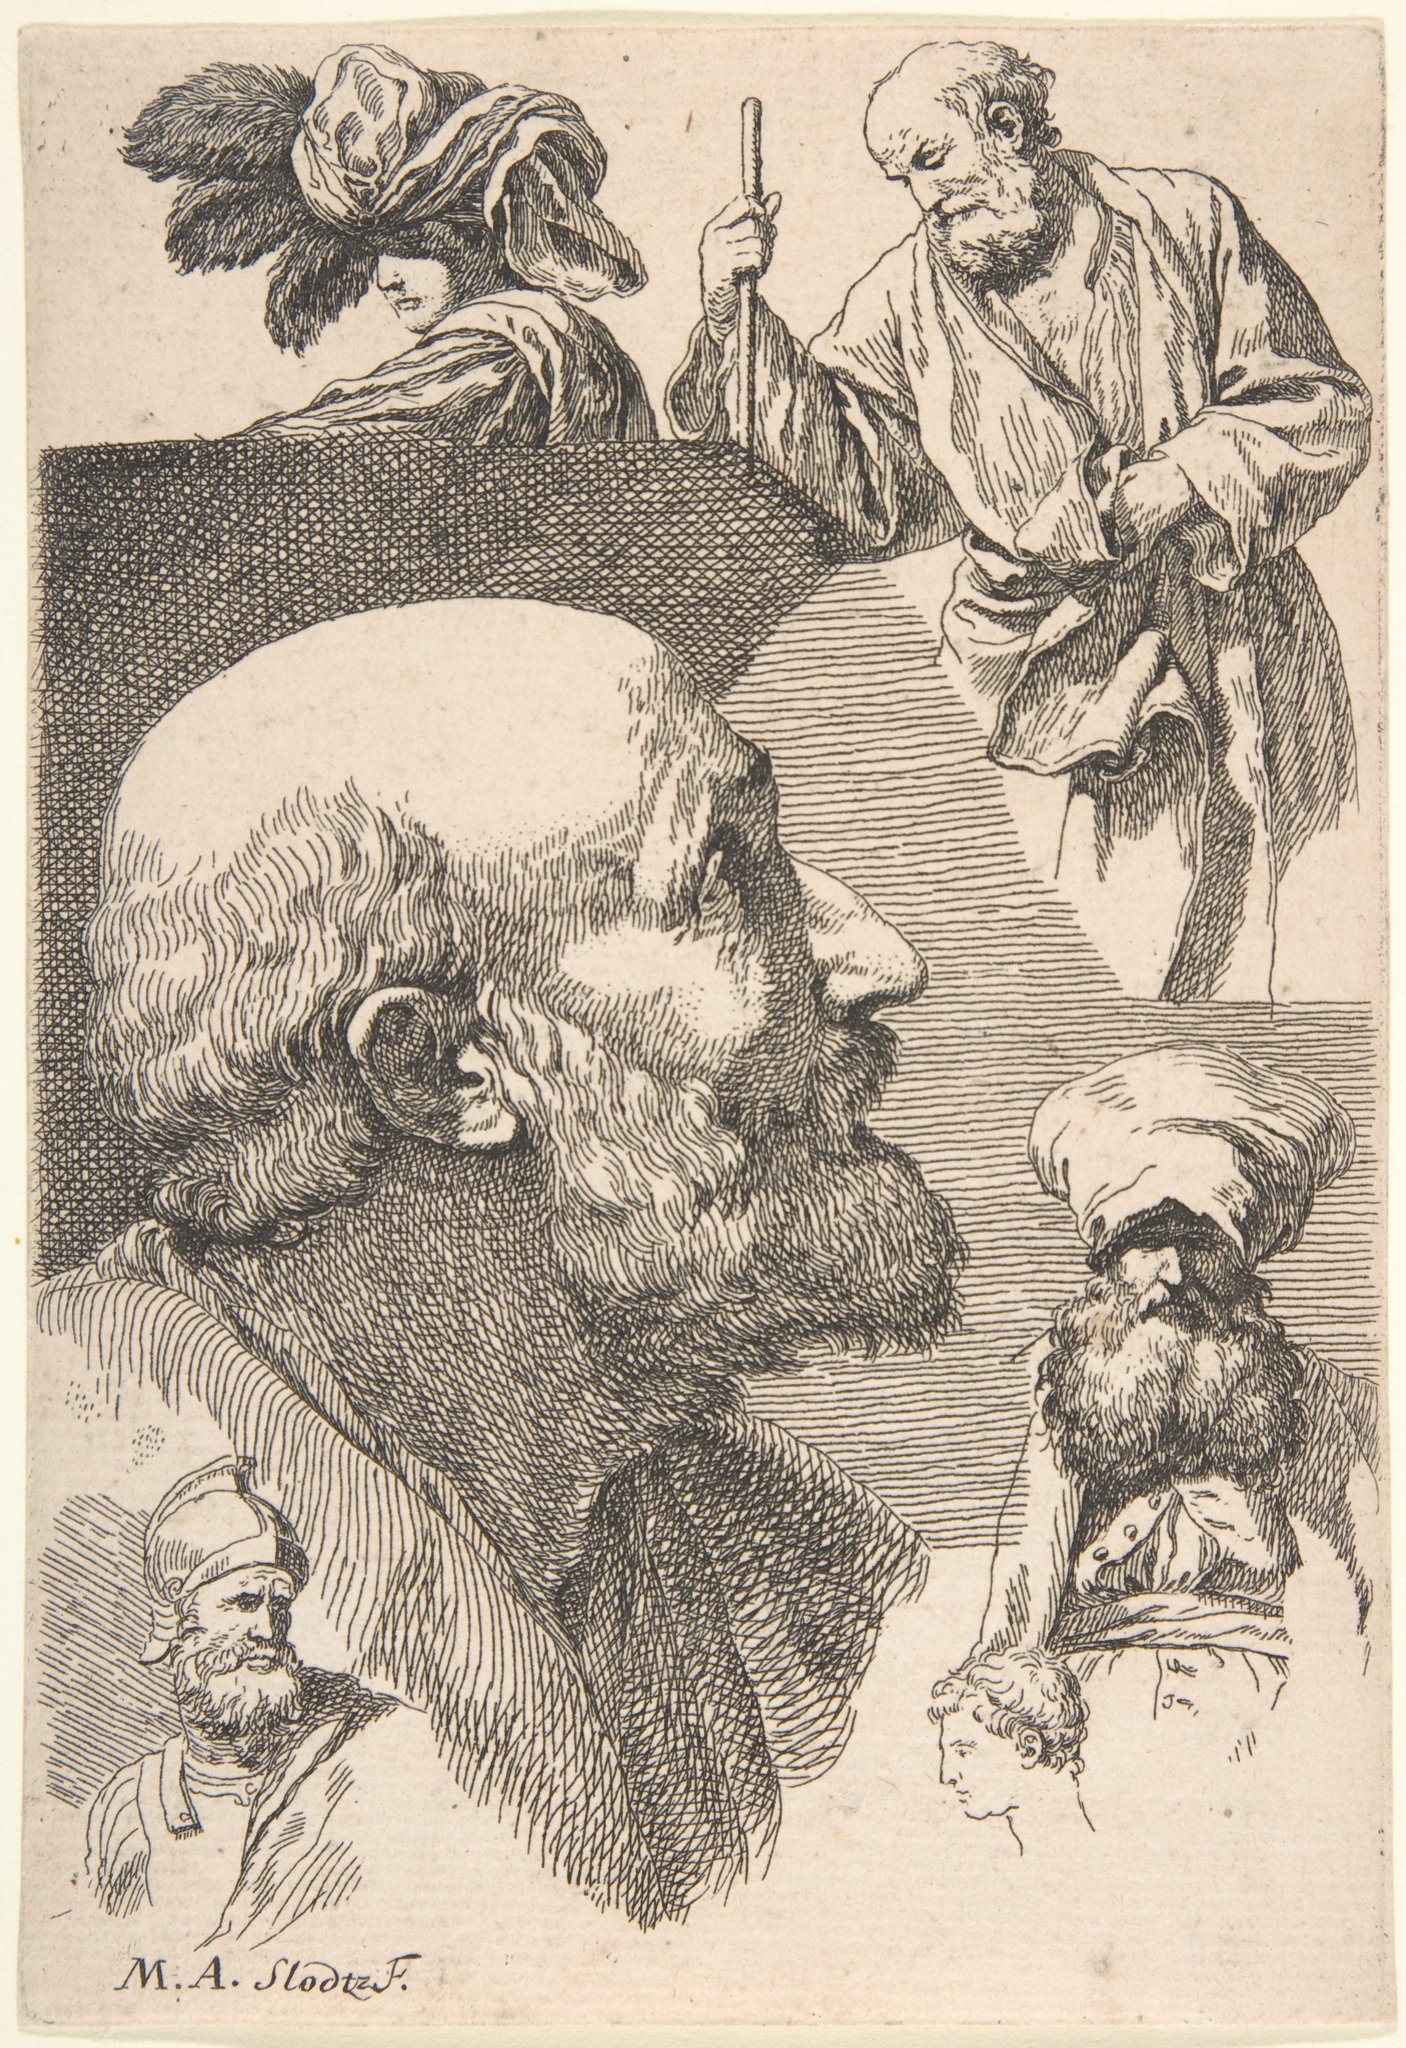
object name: print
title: Figure and Head Studies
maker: rené michel (called michel ange) slodtz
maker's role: artist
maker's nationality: french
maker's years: 1705-1764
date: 1732-1736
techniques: etching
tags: men,profiles